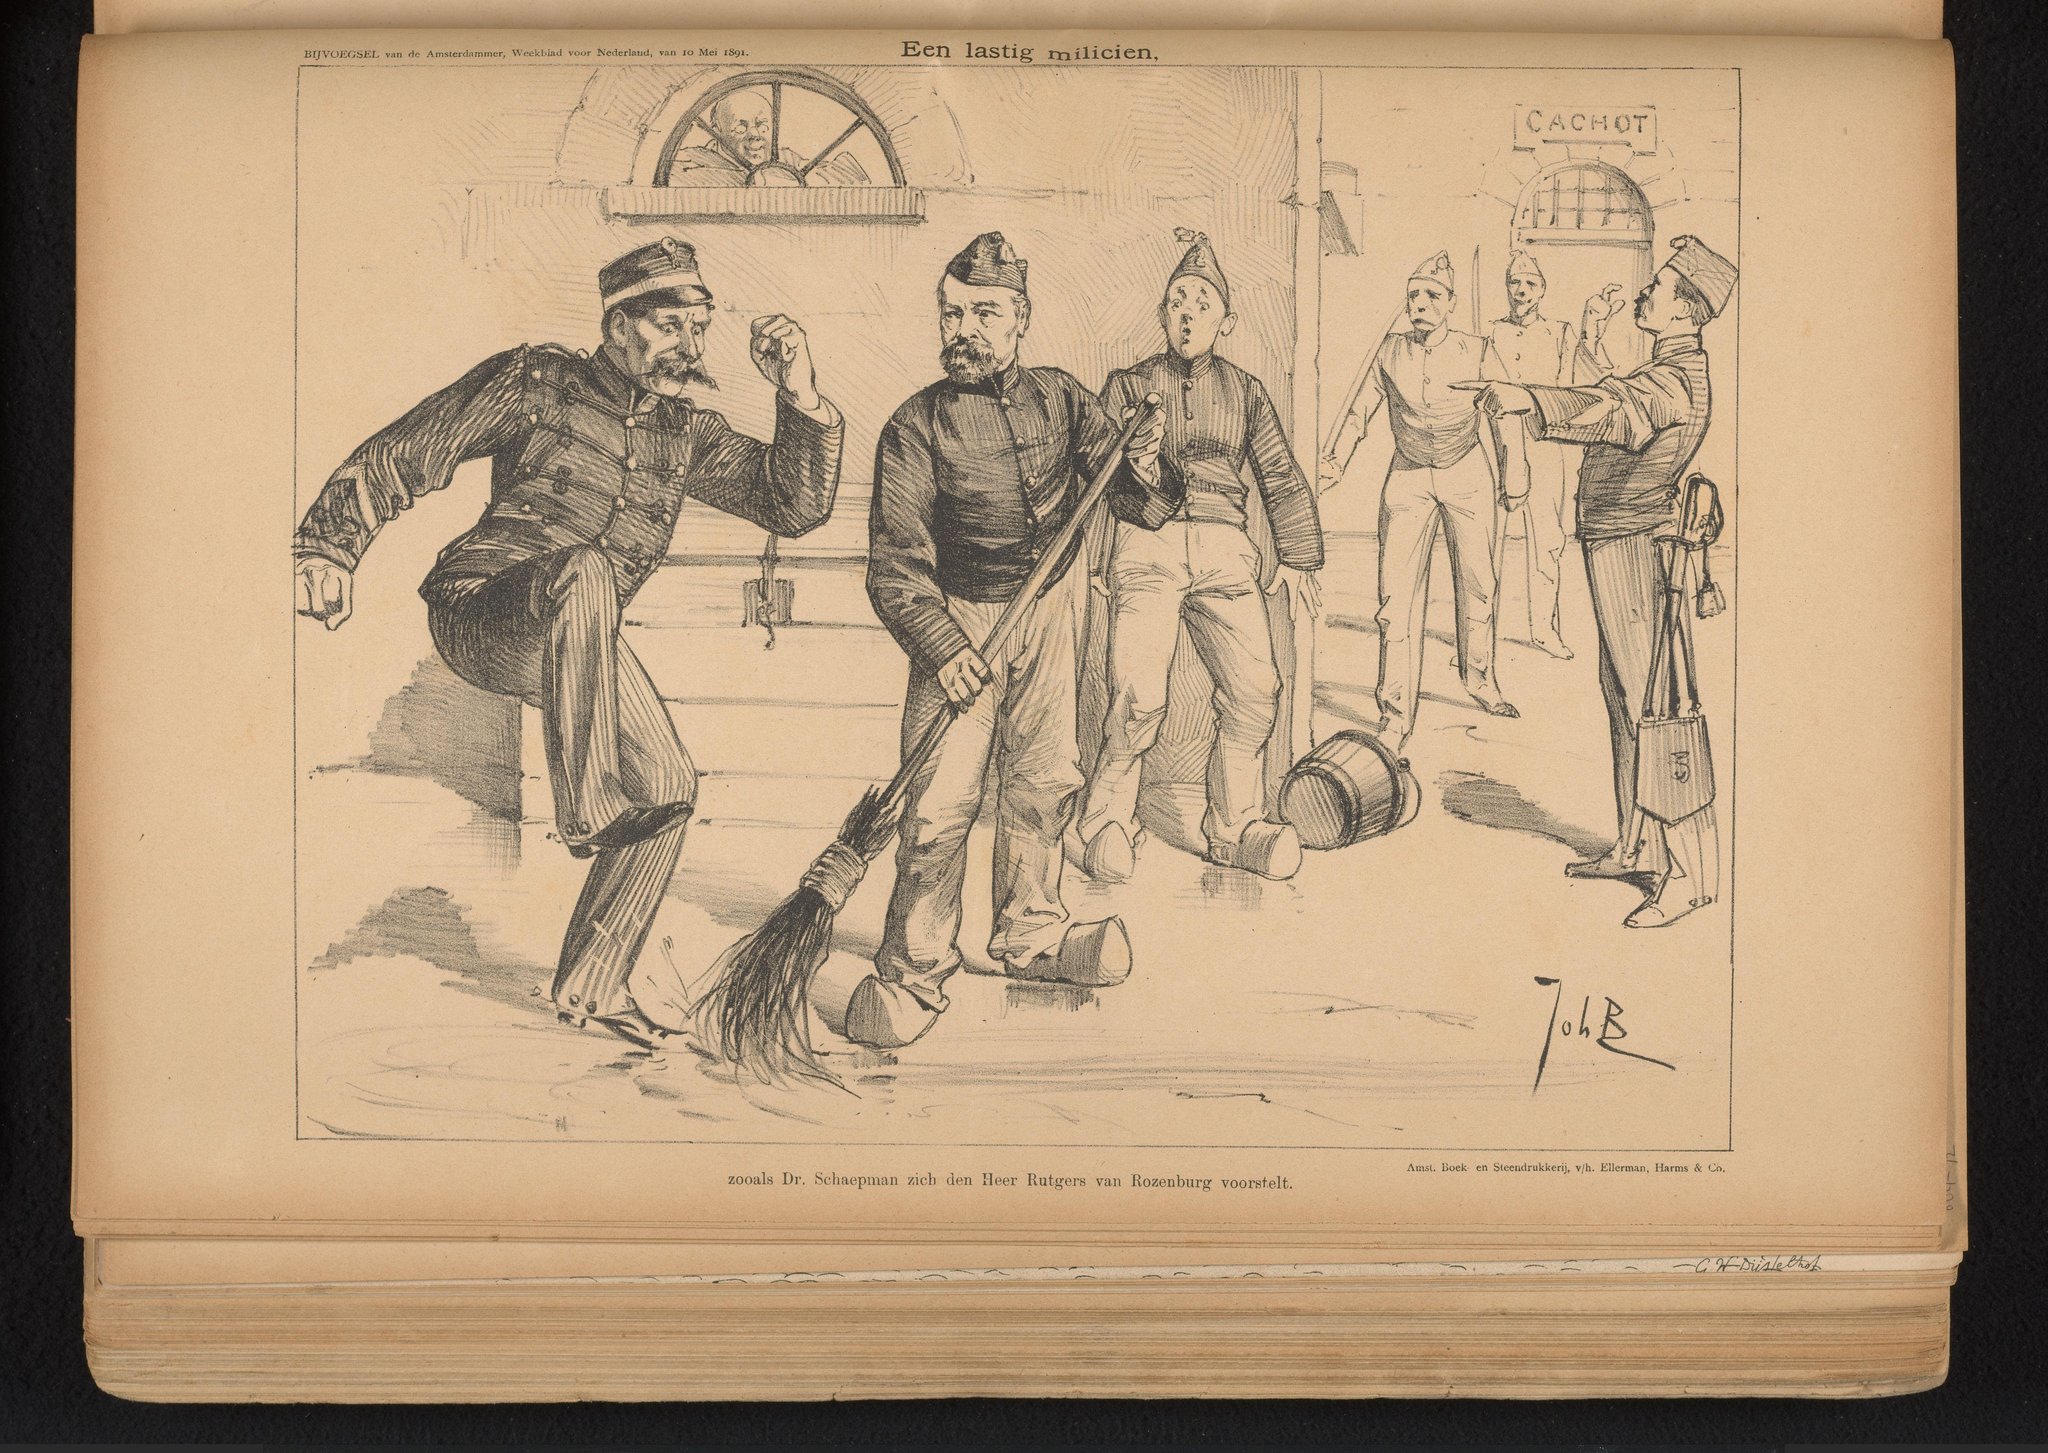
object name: cartoon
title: Een lastig milicien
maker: johan braakensiek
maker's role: draughtsman, print maker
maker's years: 1858-1940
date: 1891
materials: paper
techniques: lithograph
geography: amsterdam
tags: amsterdam, rome, priest, herman johannes aloysius maria schaepman, discipline, political caricatures and satires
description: Dr. Schaepman ziet lachend door een raampje hoe een officier boos wordt op het Tweede Kamerlid Jan Willem Hendrik Rutgers van Rozenburg die als een milicien met een bezem aan het schrobben is.